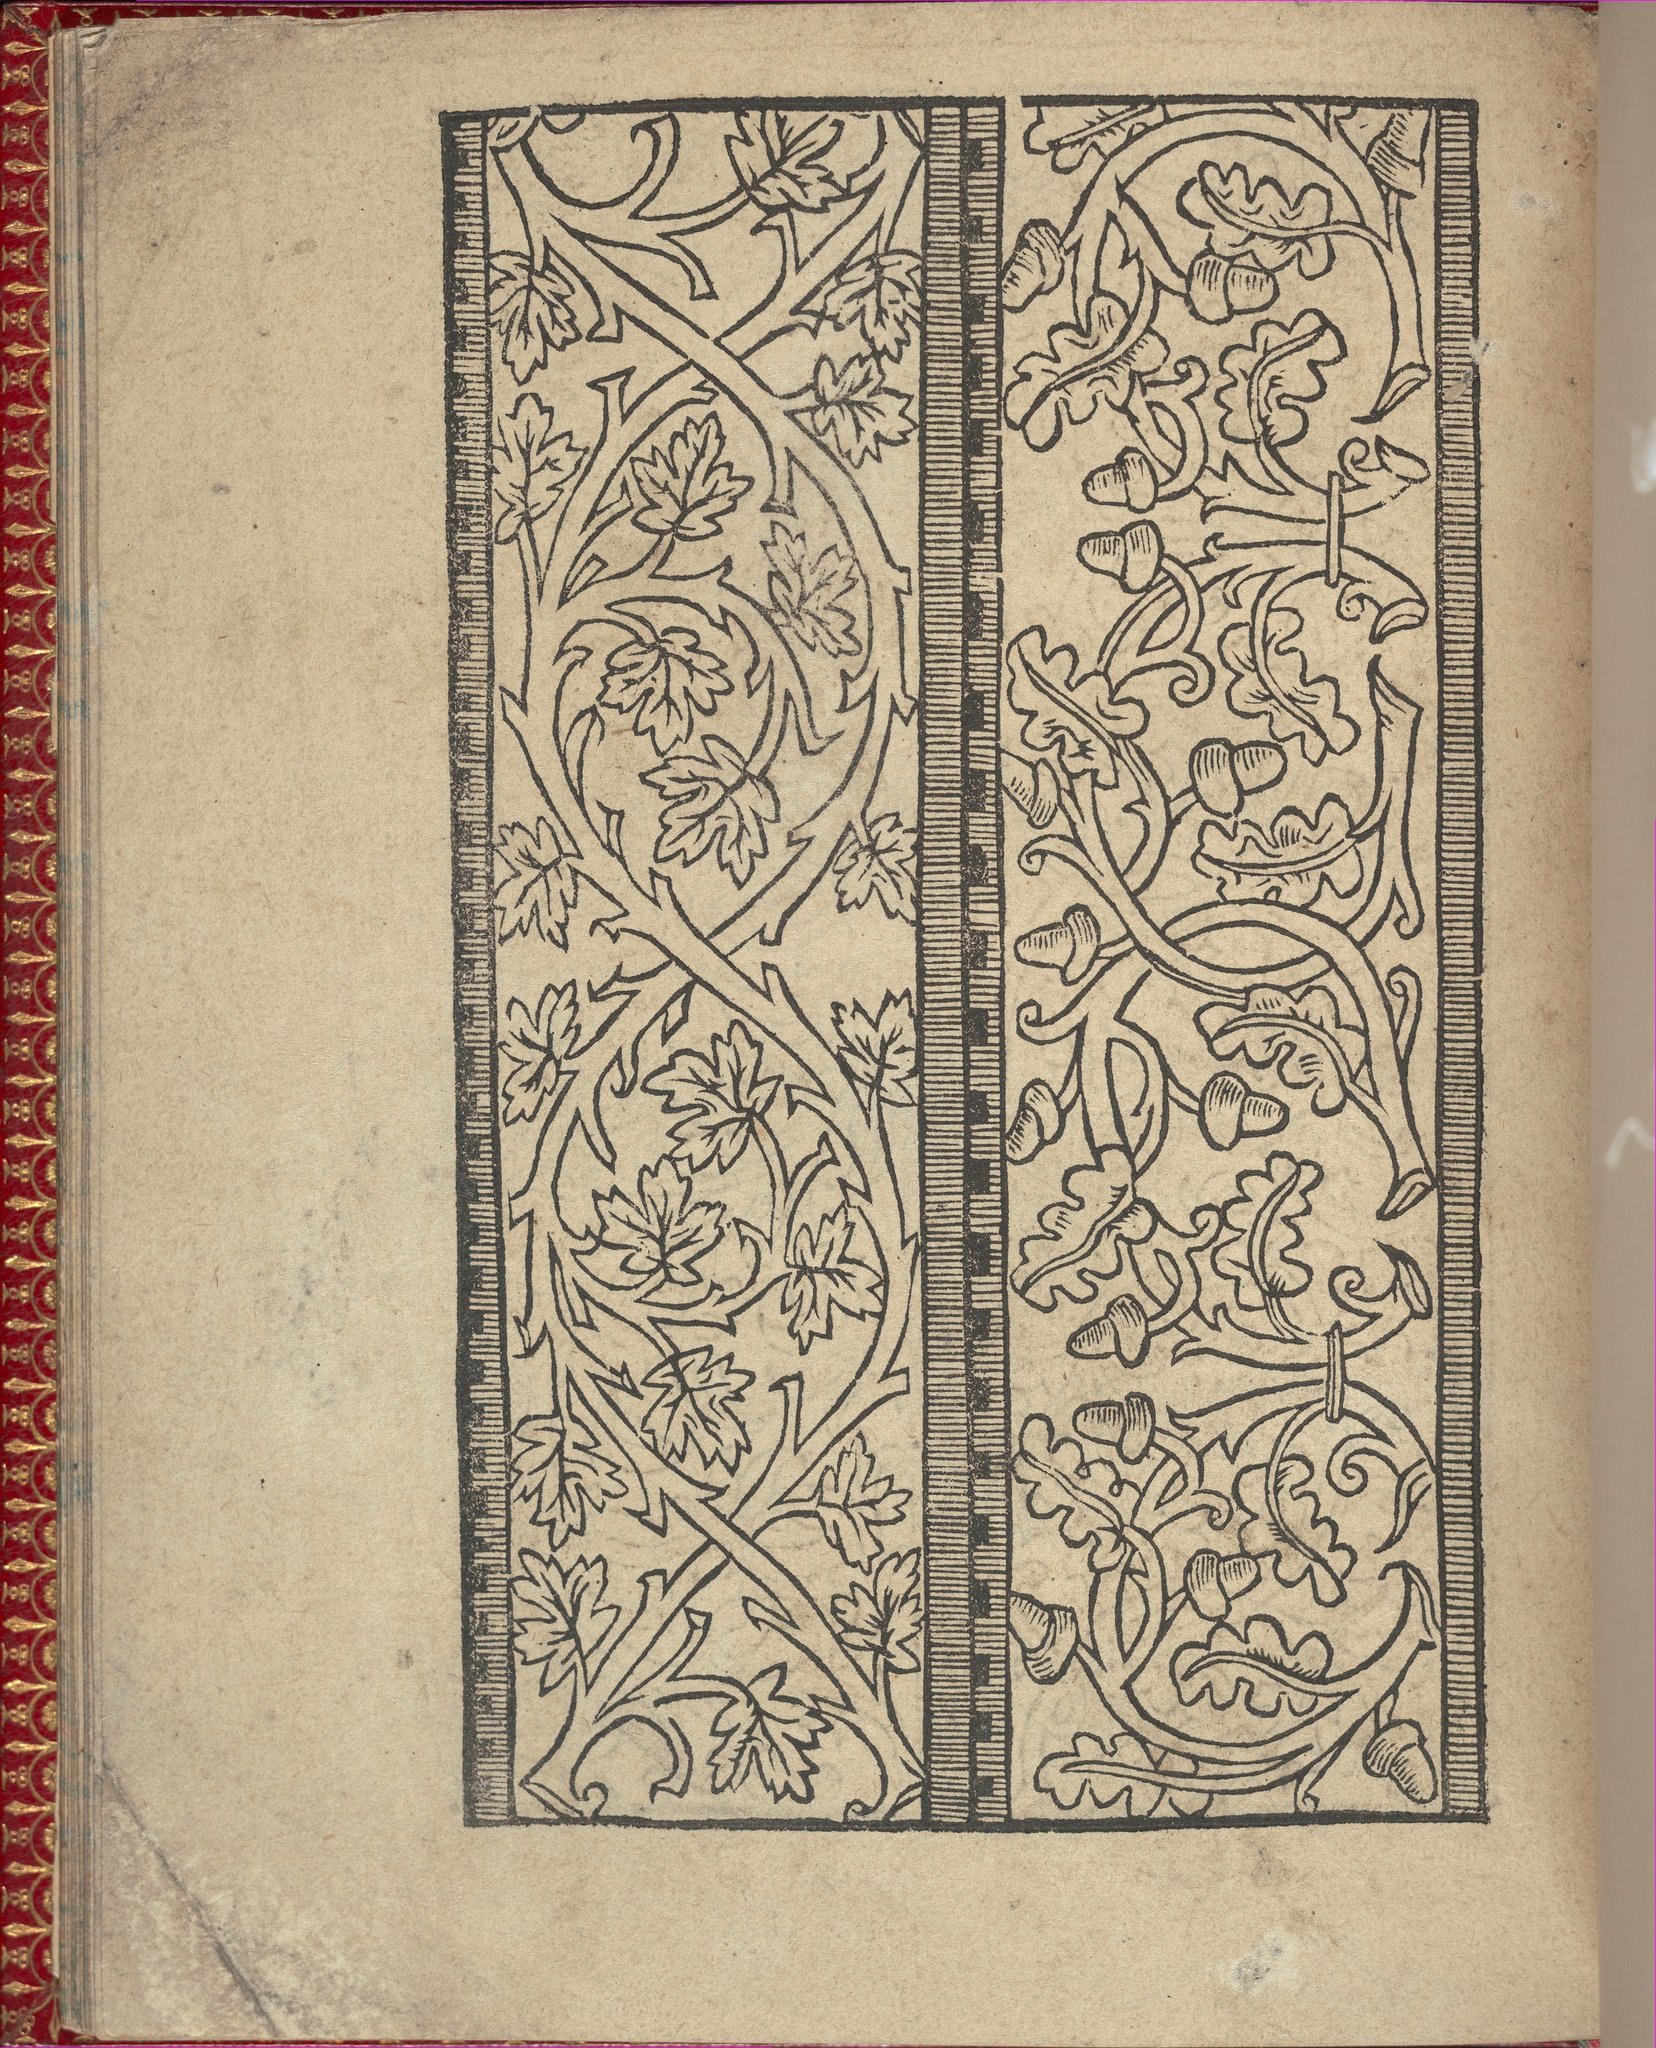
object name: book print ornament architecture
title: Ce est ung tractat de la noble art de leguille ascavoir ouvraiges de spaigne... page 13 (recto)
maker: willem vosterman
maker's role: printer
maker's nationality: netherlandish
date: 1527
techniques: woodcut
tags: ornament